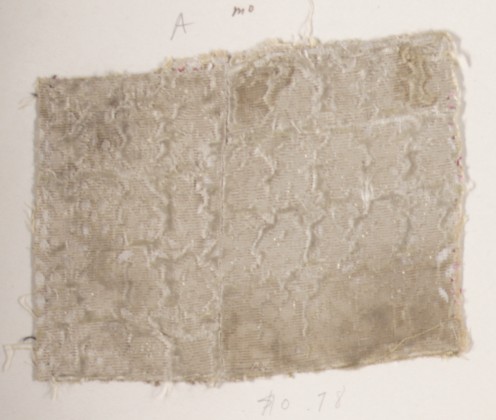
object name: fragment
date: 1701-1800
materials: metal thread, silk